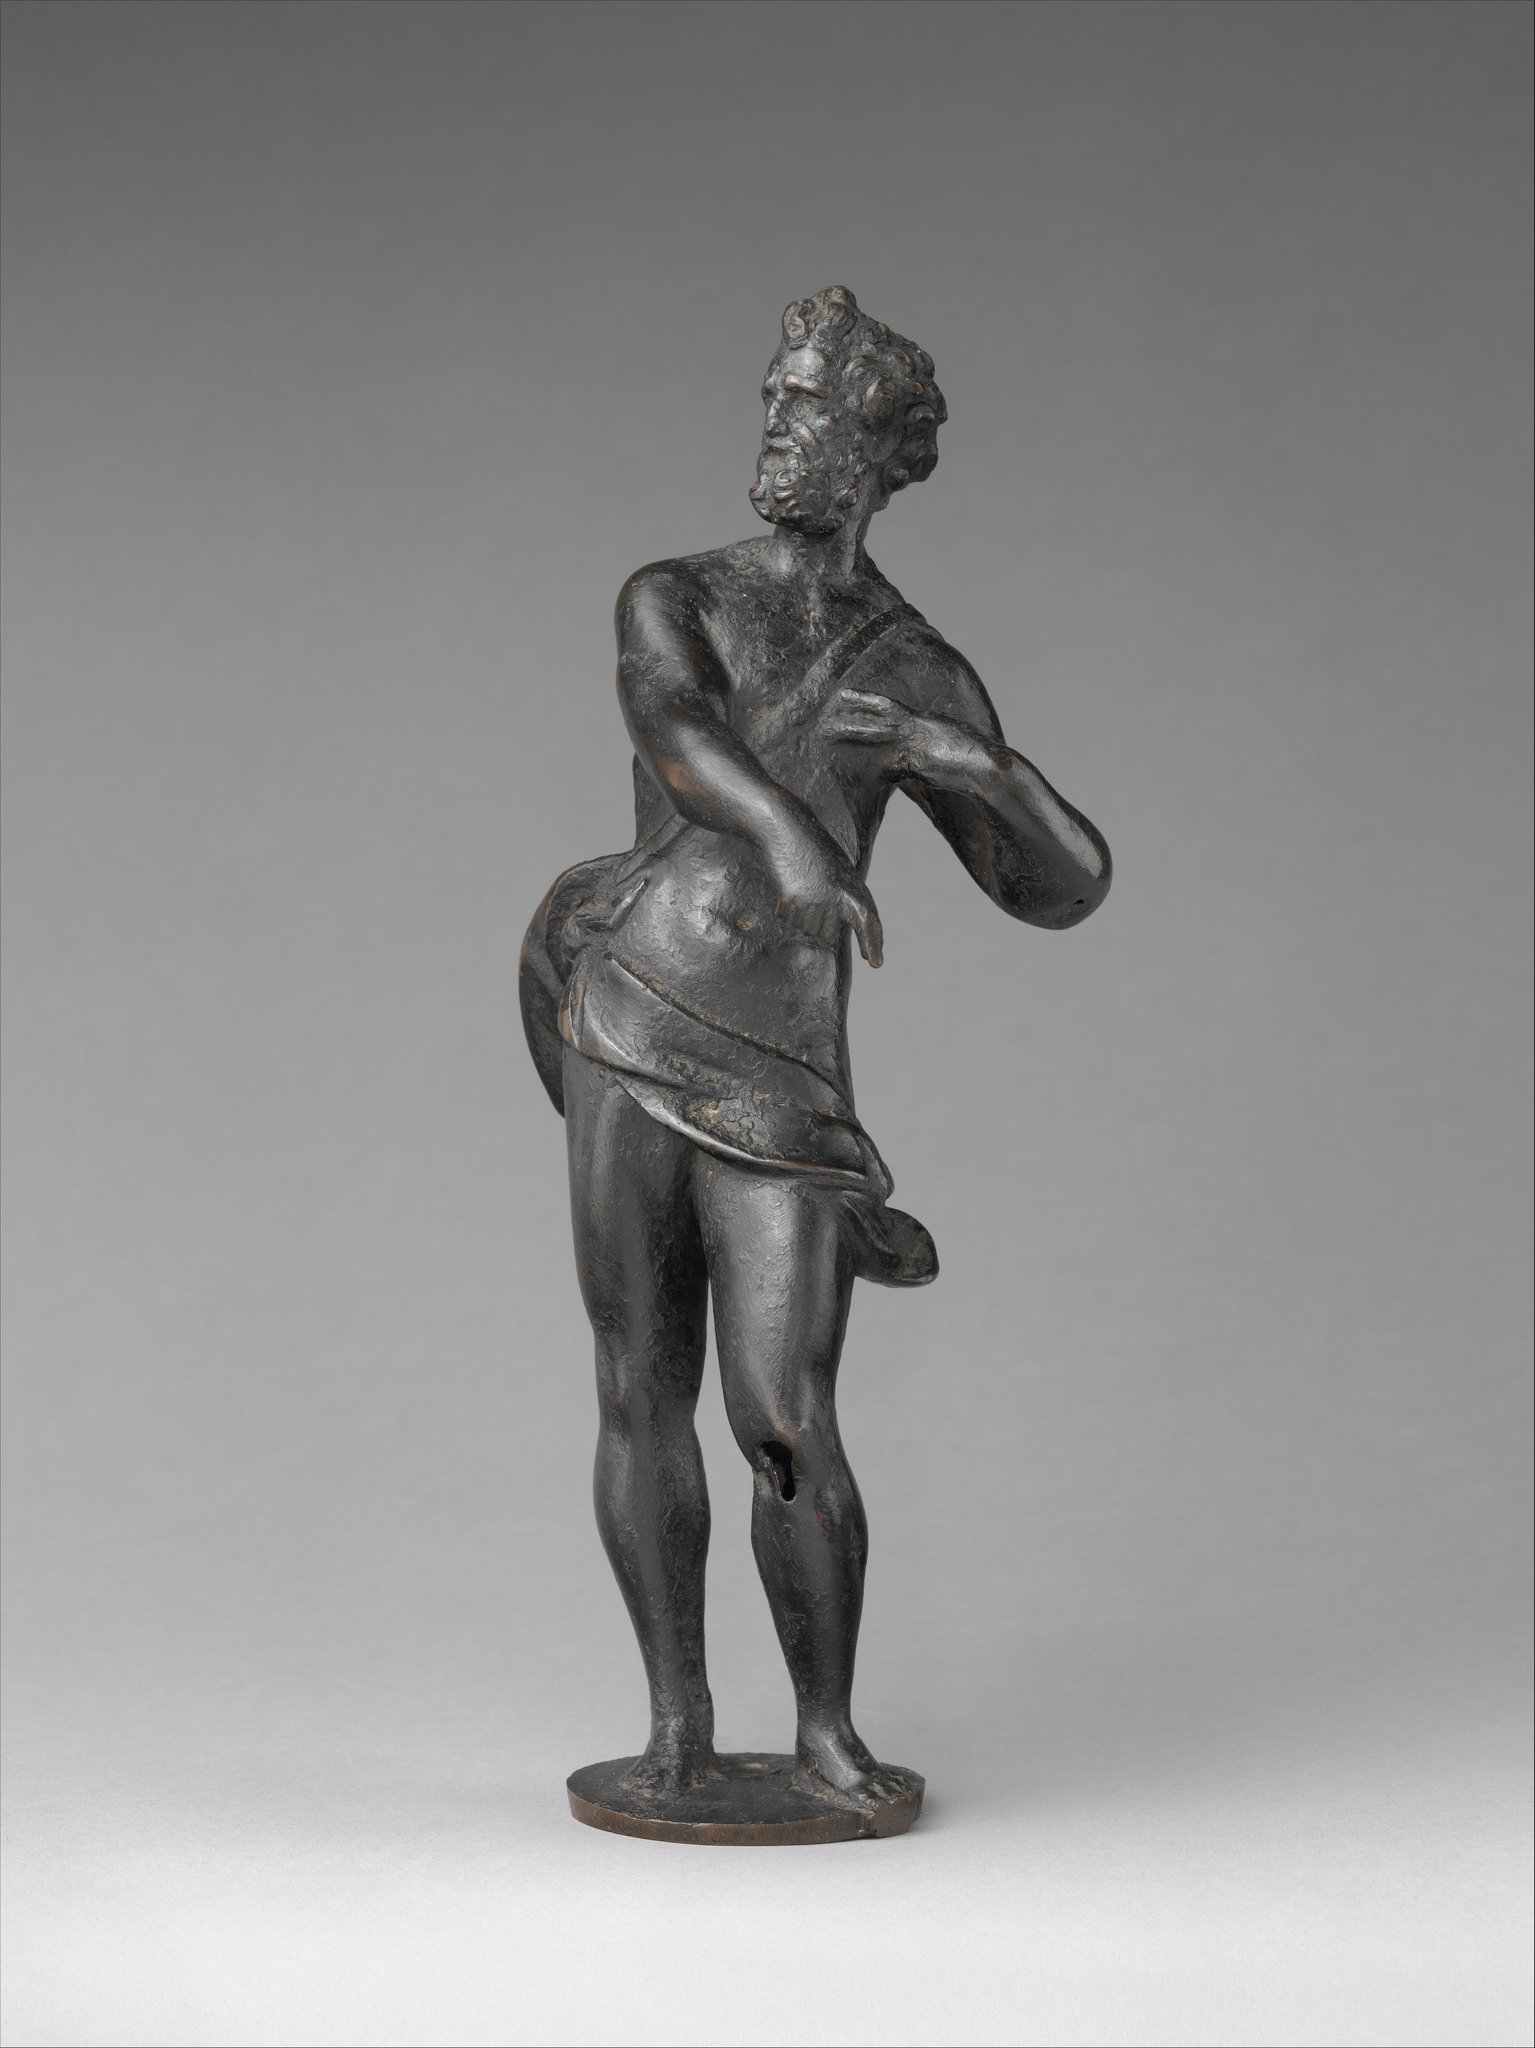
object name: statuette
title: Jupiter (?)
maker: girolamo campagna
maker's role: artist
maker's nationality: italian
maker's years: 1549-1625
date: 1567-1600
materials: bronze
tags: vulcan